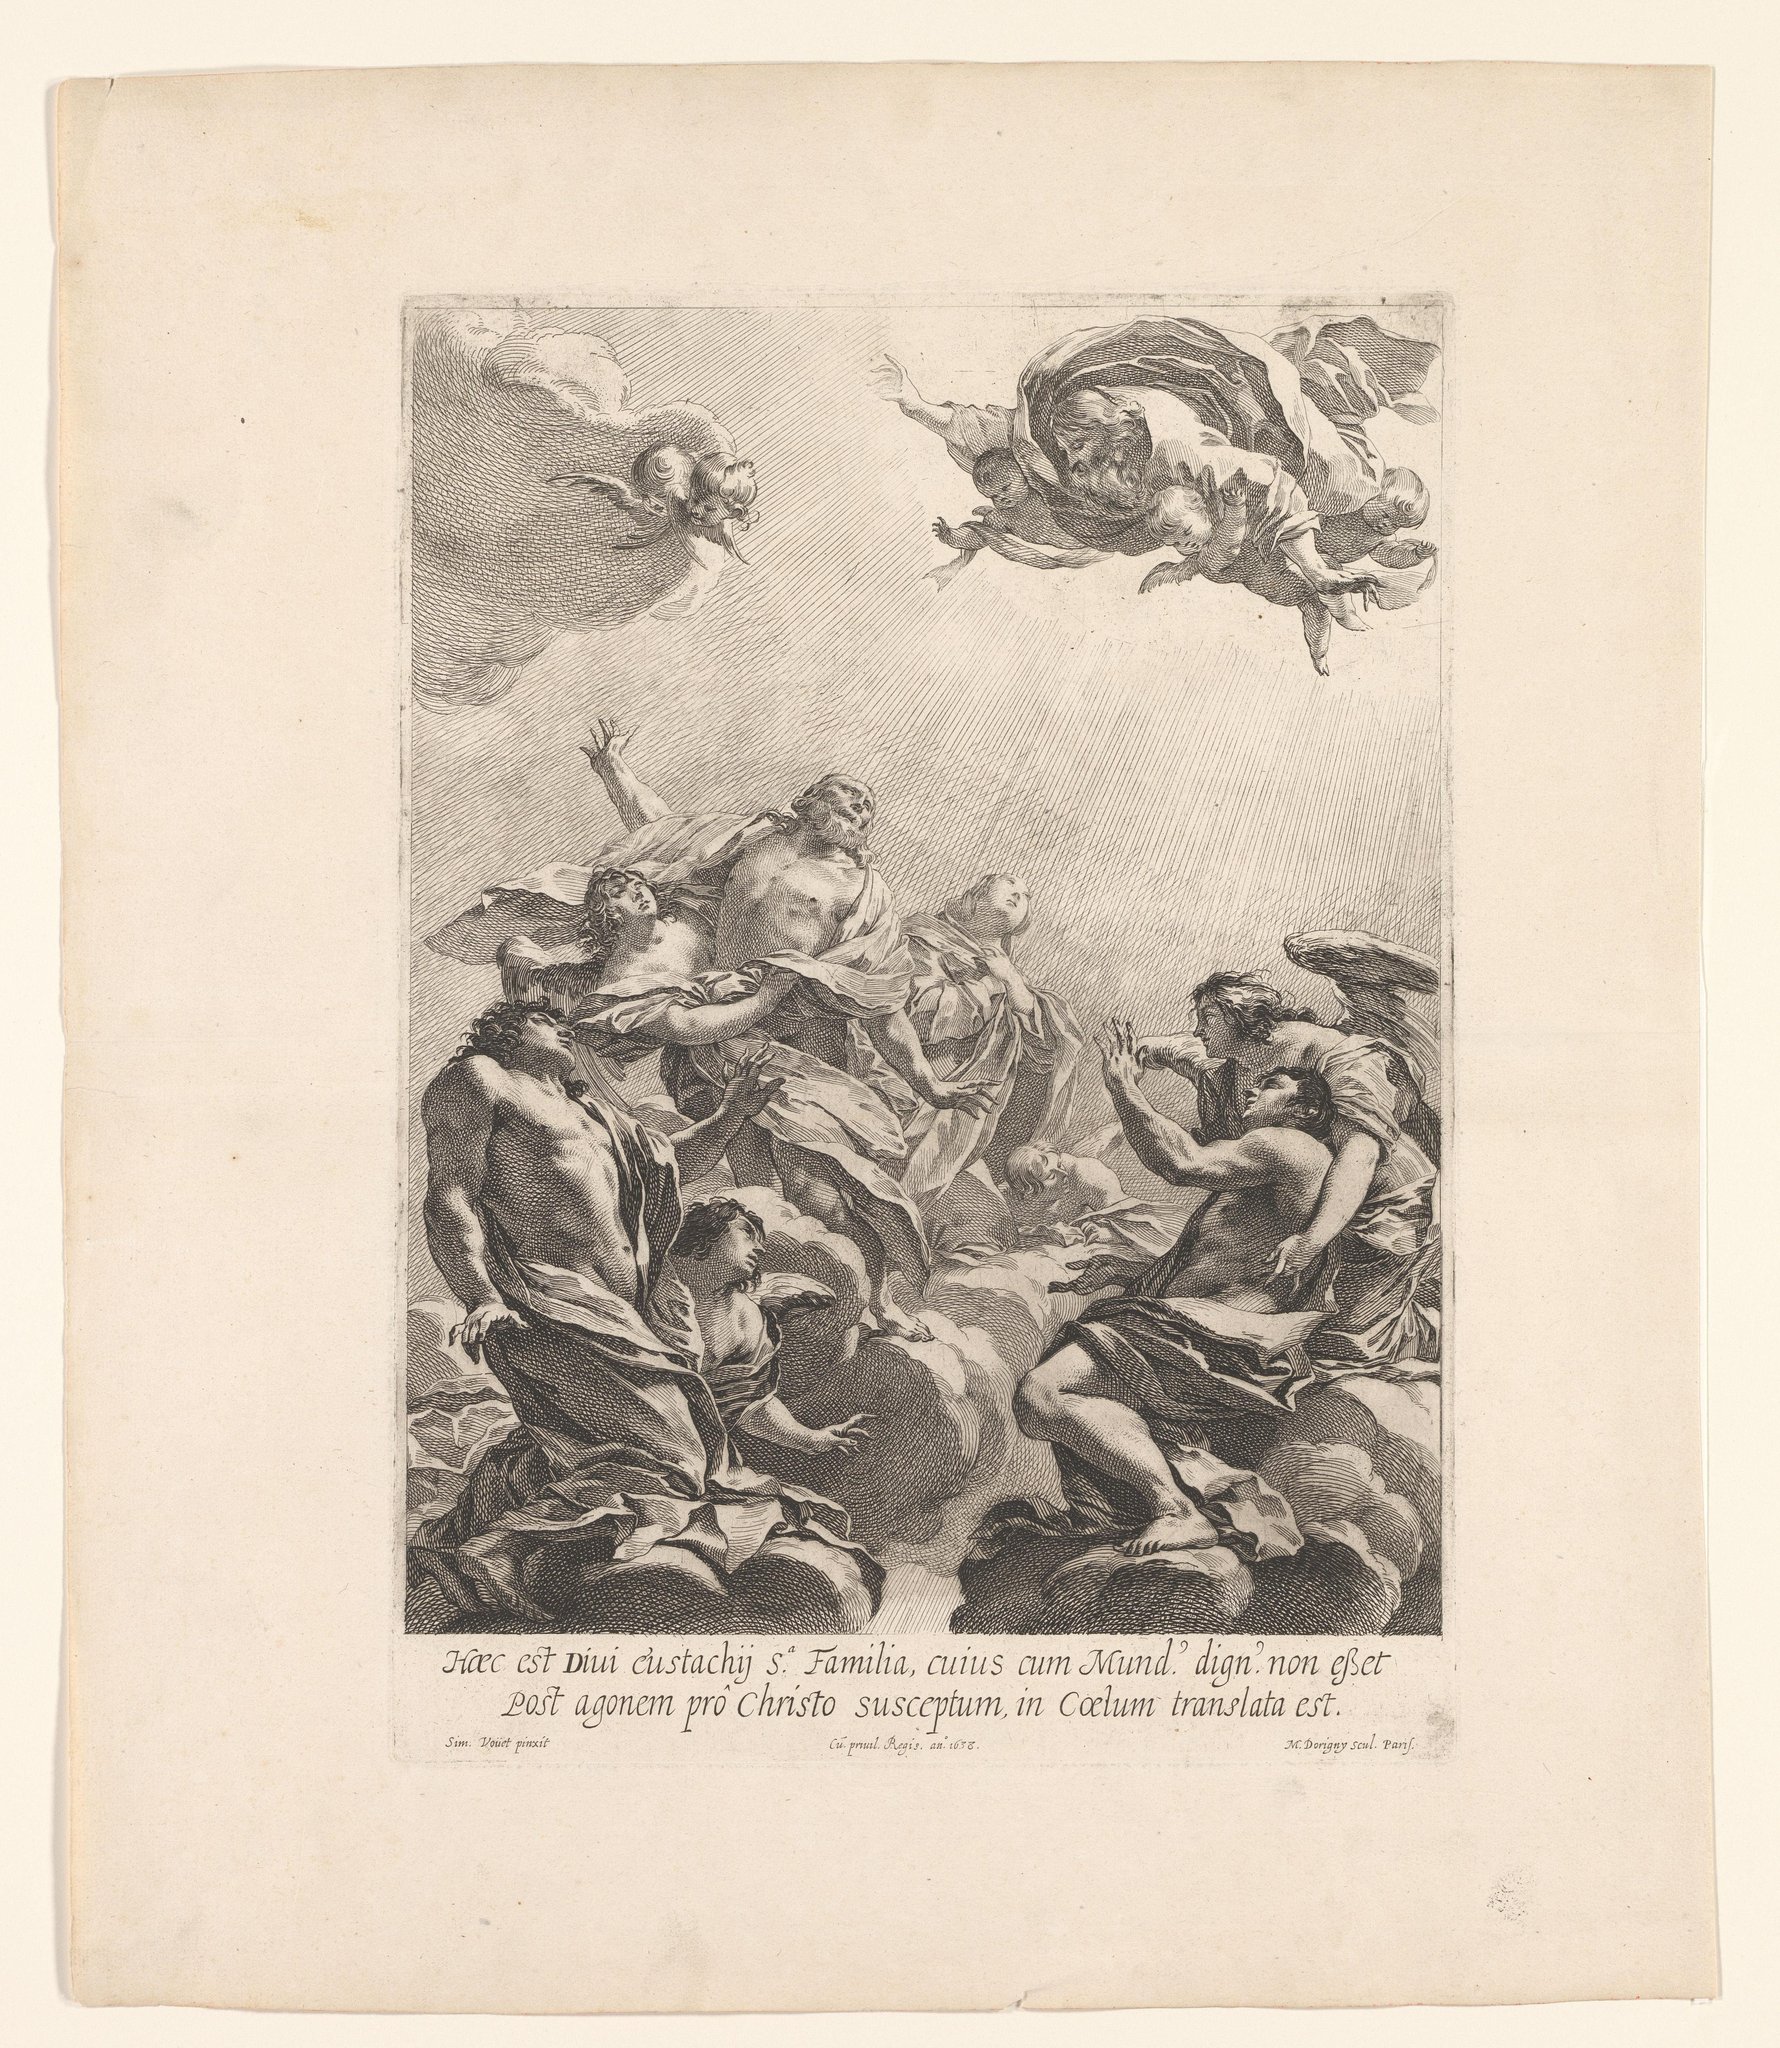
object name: print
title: Familie van Eustachius van Rome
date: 1638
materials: paper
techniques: engraving, etching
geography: paris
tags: the roman soldier and hunter eustace (eustachius, eustathius); possible attributes: banner, bull of brass, cuirass, hunting horn, lance, stag's head with crucifix, sword, two sons, wife - apotheosis, glory, triumph of male saint, family, descendance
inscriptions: collector's mark: Lugt 2228